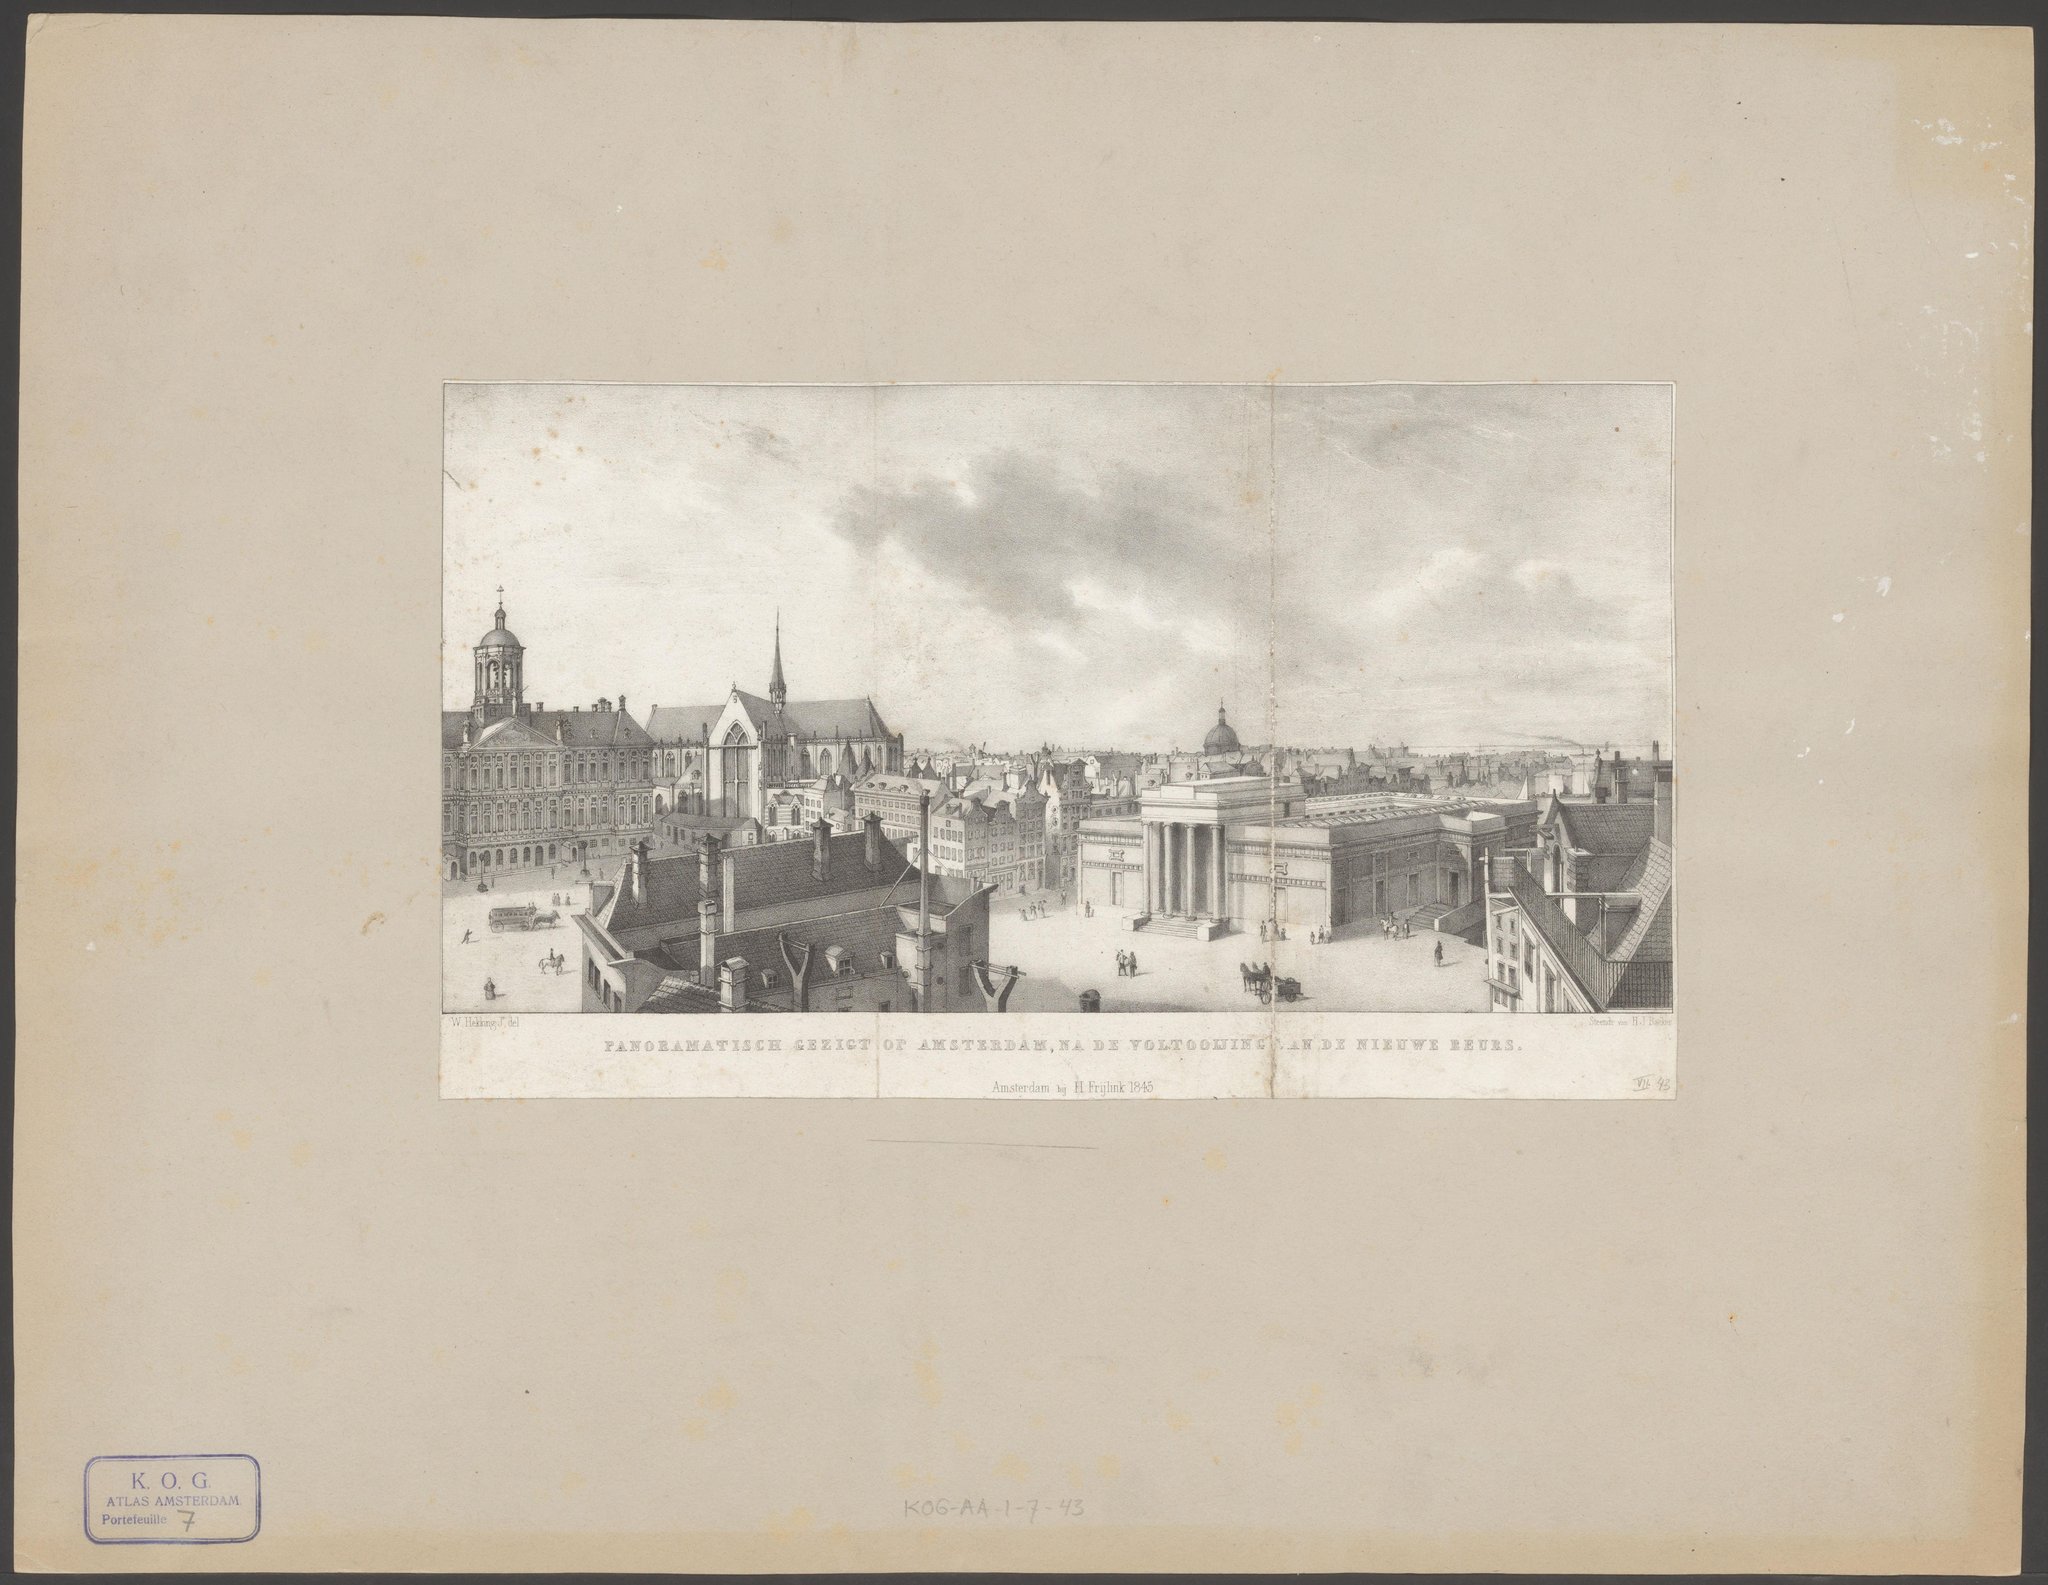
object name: print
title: Gezicht op het Paleis op de Dam, de Nieuwe Kerke en de Beurs van Zocher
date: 1845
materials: paper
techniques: lithograph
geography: amsterdam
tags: square, place, circus, etc., city-view in general; 'veduta', palace, church (exterior), market-hall, royal palace of amsterdam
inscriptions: collector's mark: ‘7’ Lugt 1641b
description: Onderwerpsrubriek binnen de Atlas Amsterdam: Dam (na 1835).